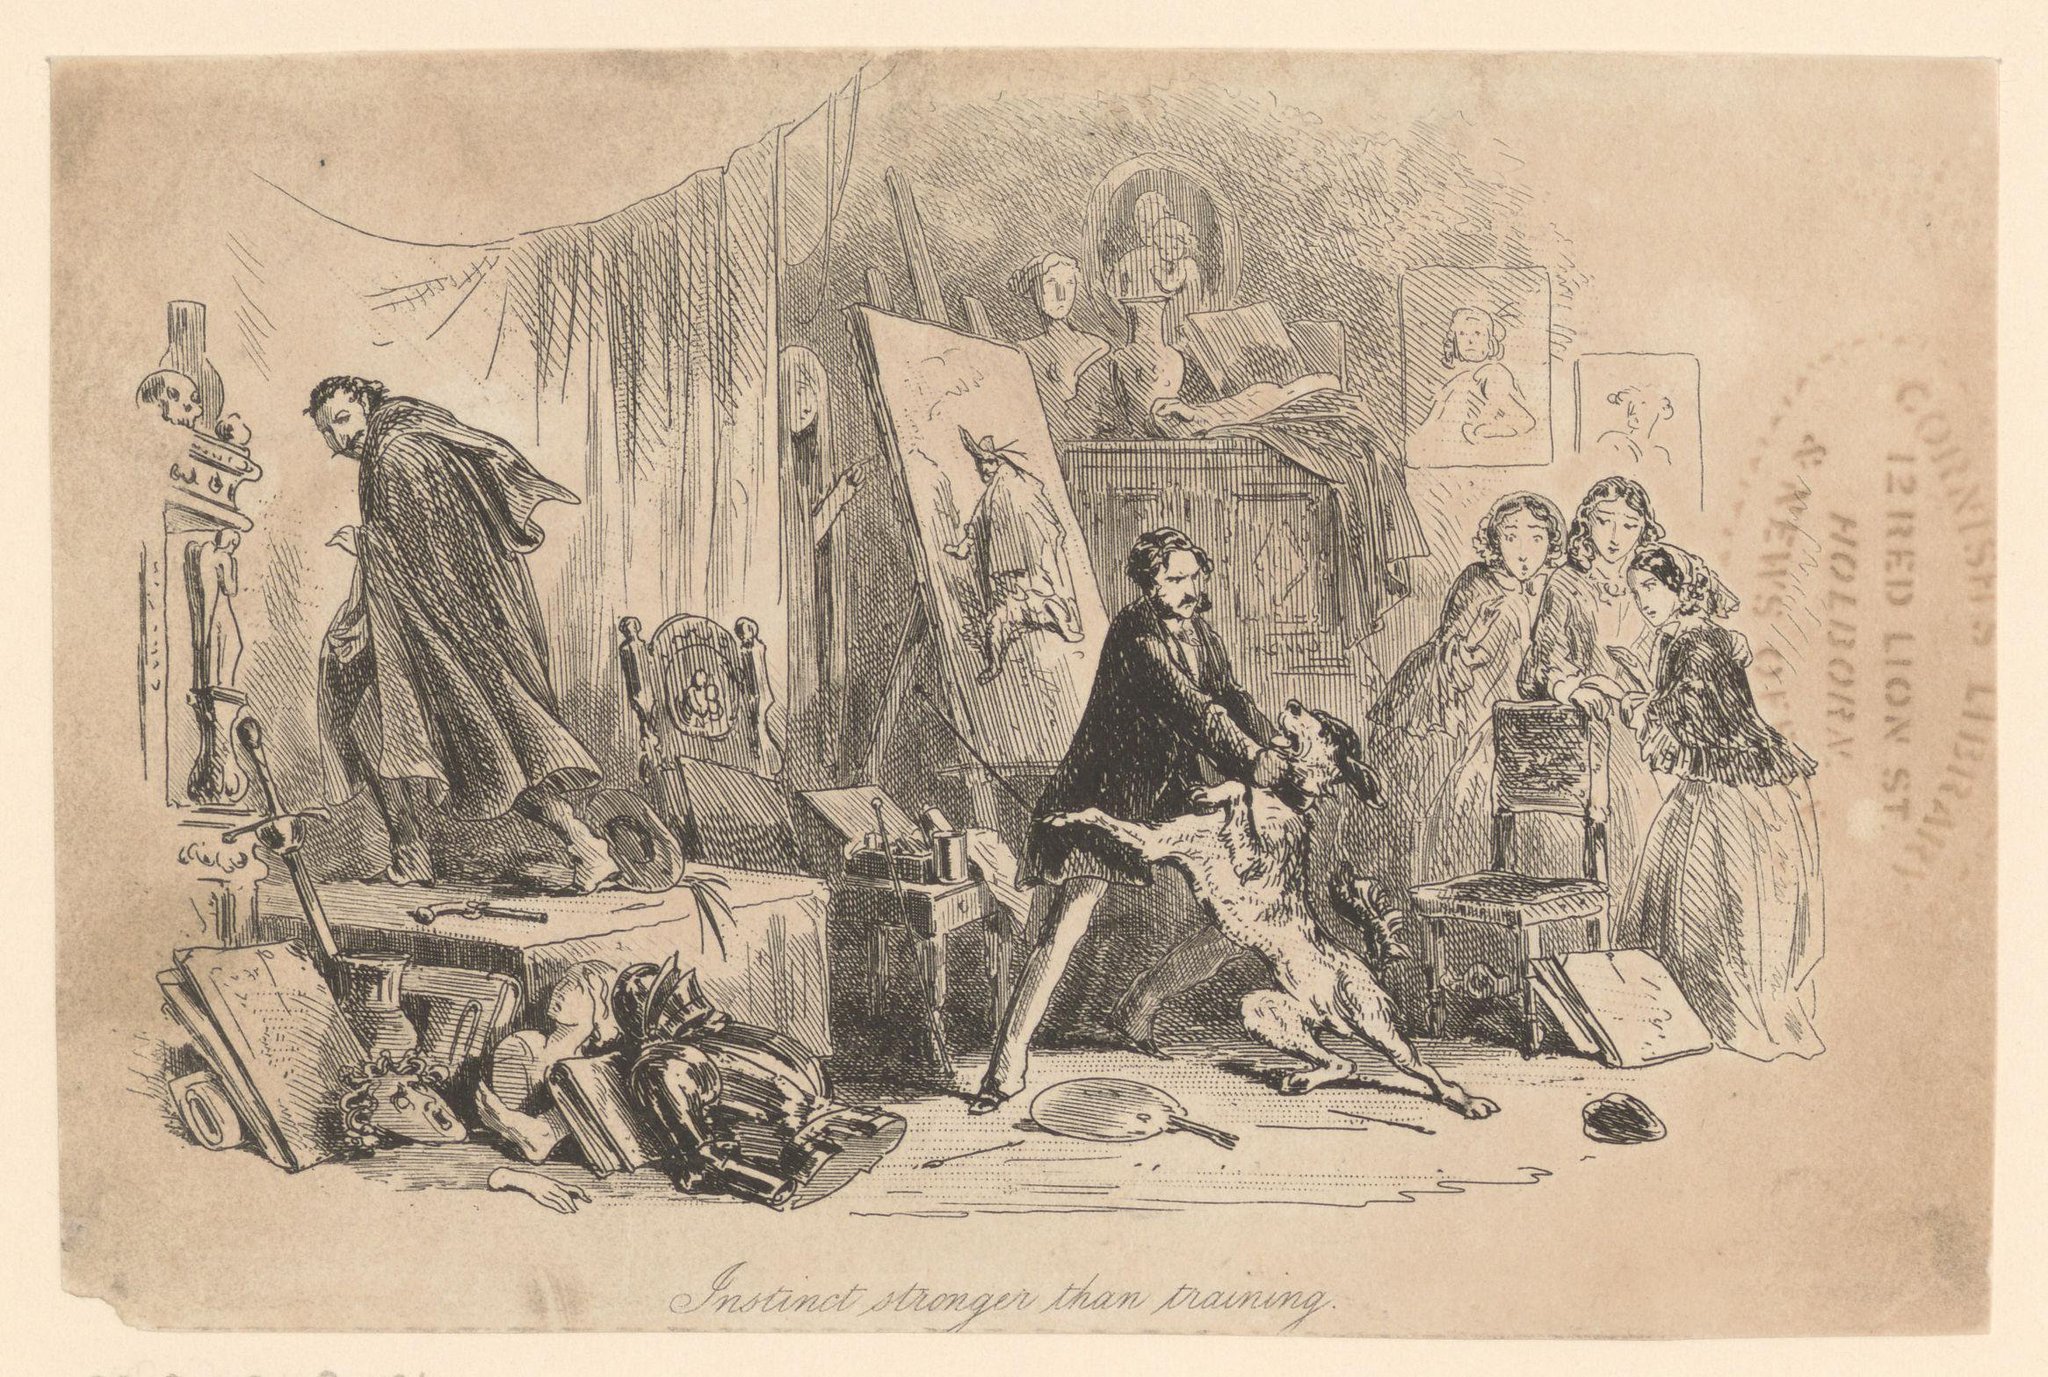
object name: print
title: In zijn atelier houdt Henry Gowan zijn hond in bedwang, die zojuist de crimineel Rigaud heeft herkend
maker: hablot knight browne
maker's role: print maker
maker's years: 1815-1882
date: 1811-1856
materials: paper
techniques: etching, roulette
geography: london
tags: artist's model, sitter, picture, painting, artist at work, in his workshop, recognizing, murderer, dog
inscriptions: stamp: ‘Cornish's Library 12 Red Lion St. Holborn & News Office’, collector's mark: Lugt 2228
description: Prent uit: Dickens, Charles. Little Dorrit. Londen: Bradbury & Evans, 1857. Het boek werd tussen 1855 en 1857 eerst in delen uitgegeven. Deze prent werd voor het eerst uitgegeven in november 1856.